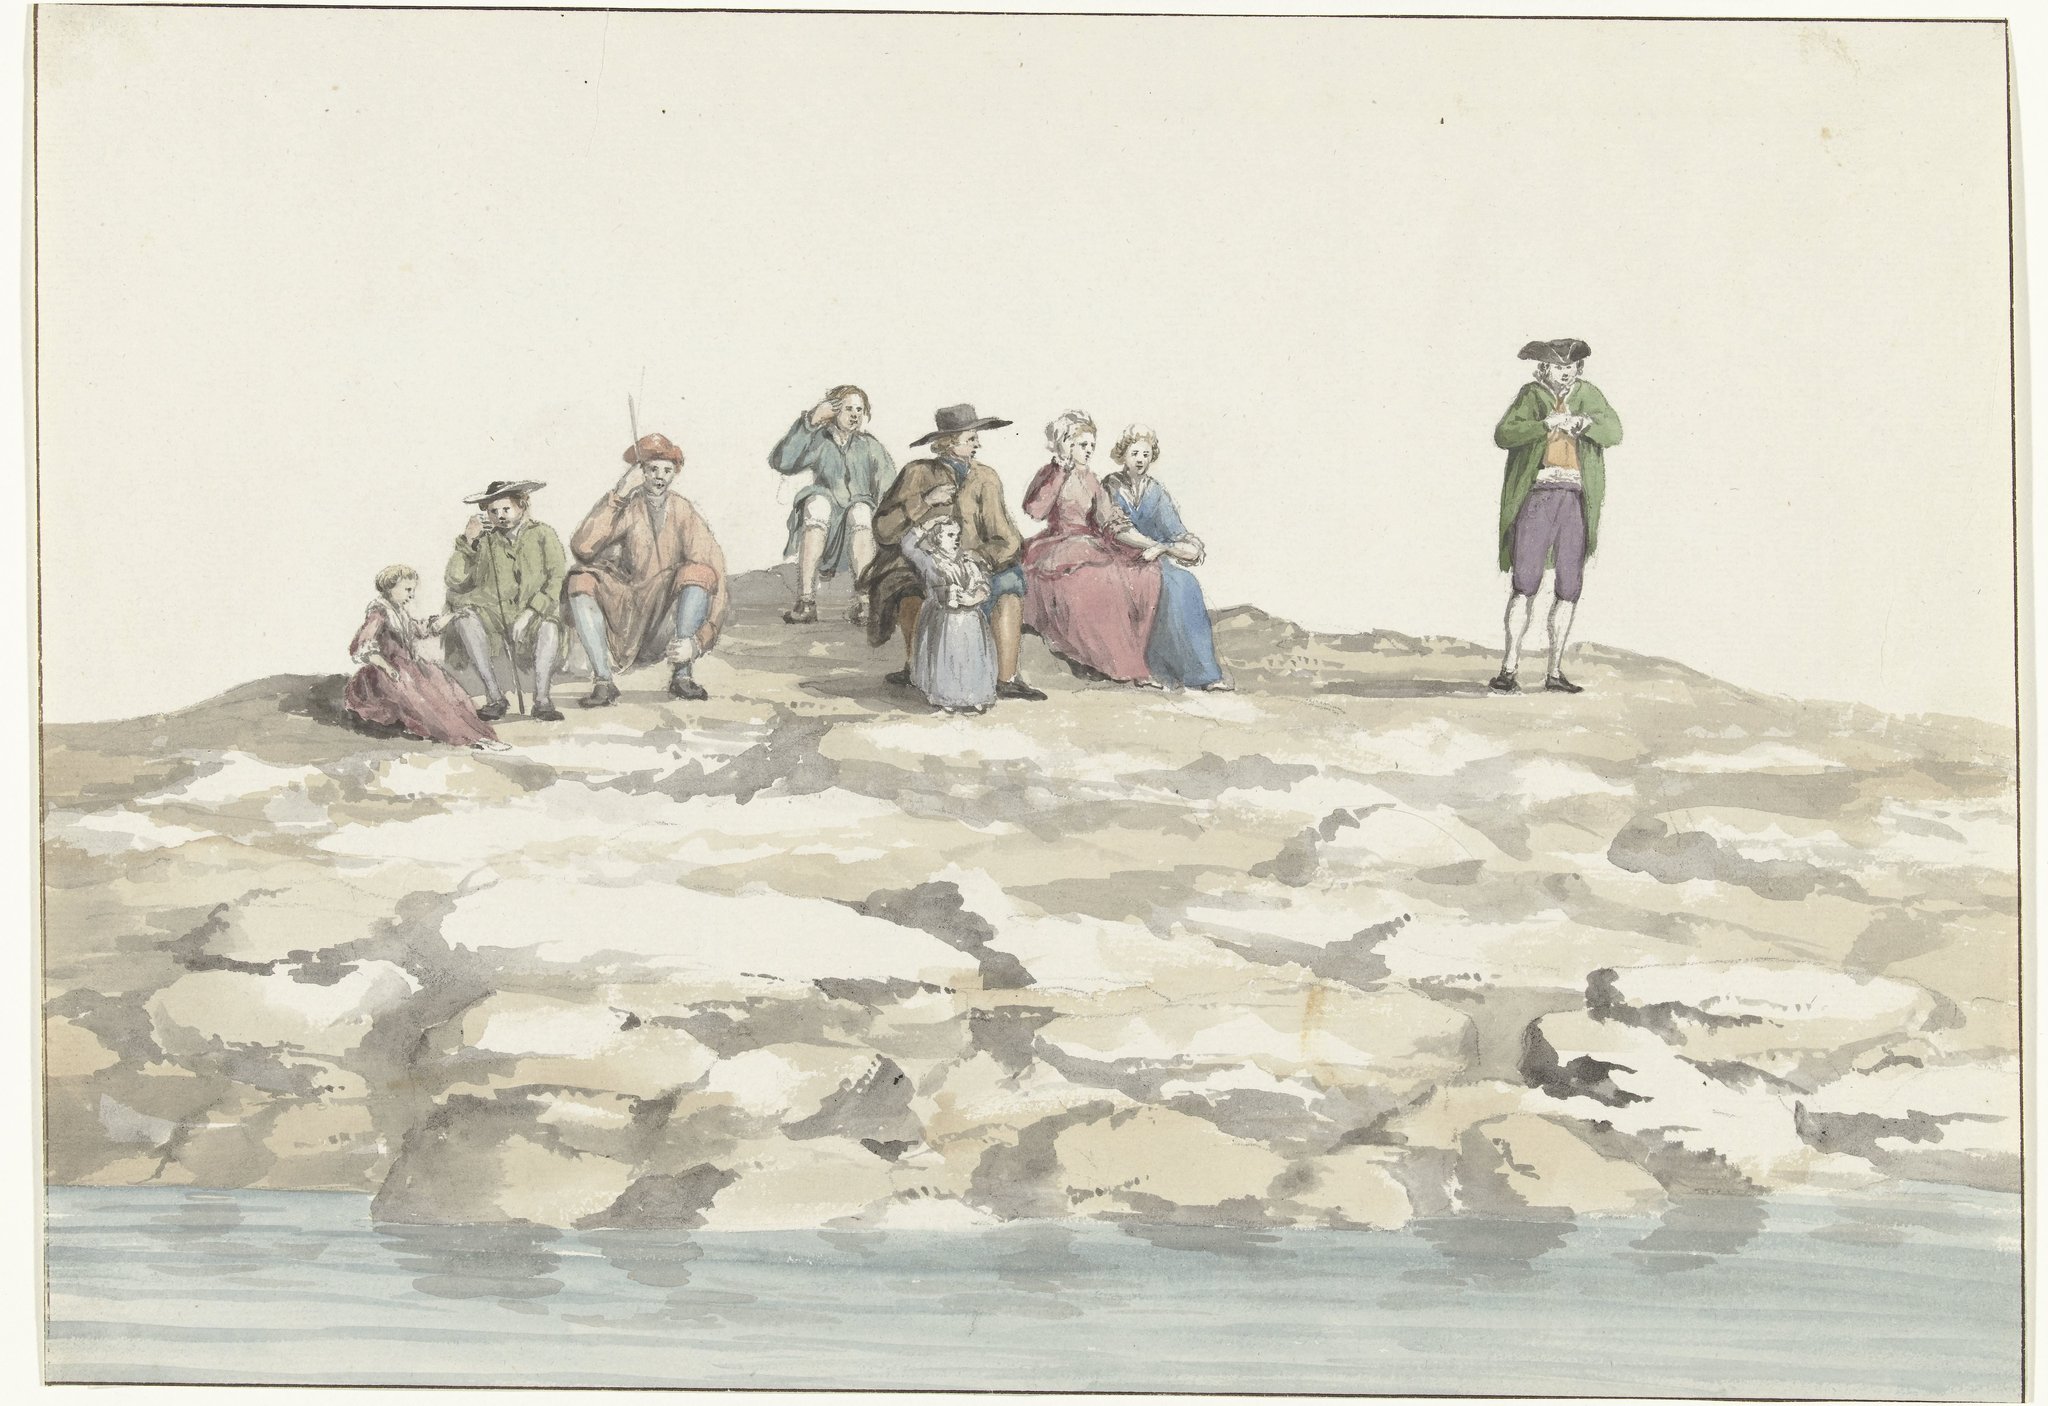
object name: drawing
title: Toeschouwers bij het vertrek uit de haven van Luogo Vivo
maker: louis ducros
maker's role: draughtsman, print maker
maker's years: 1748-1810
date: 1778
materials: chalk, paper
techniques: brush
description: Tekening uit het album 'Voyage en Italie, en Sicile et à Malte', 1778.